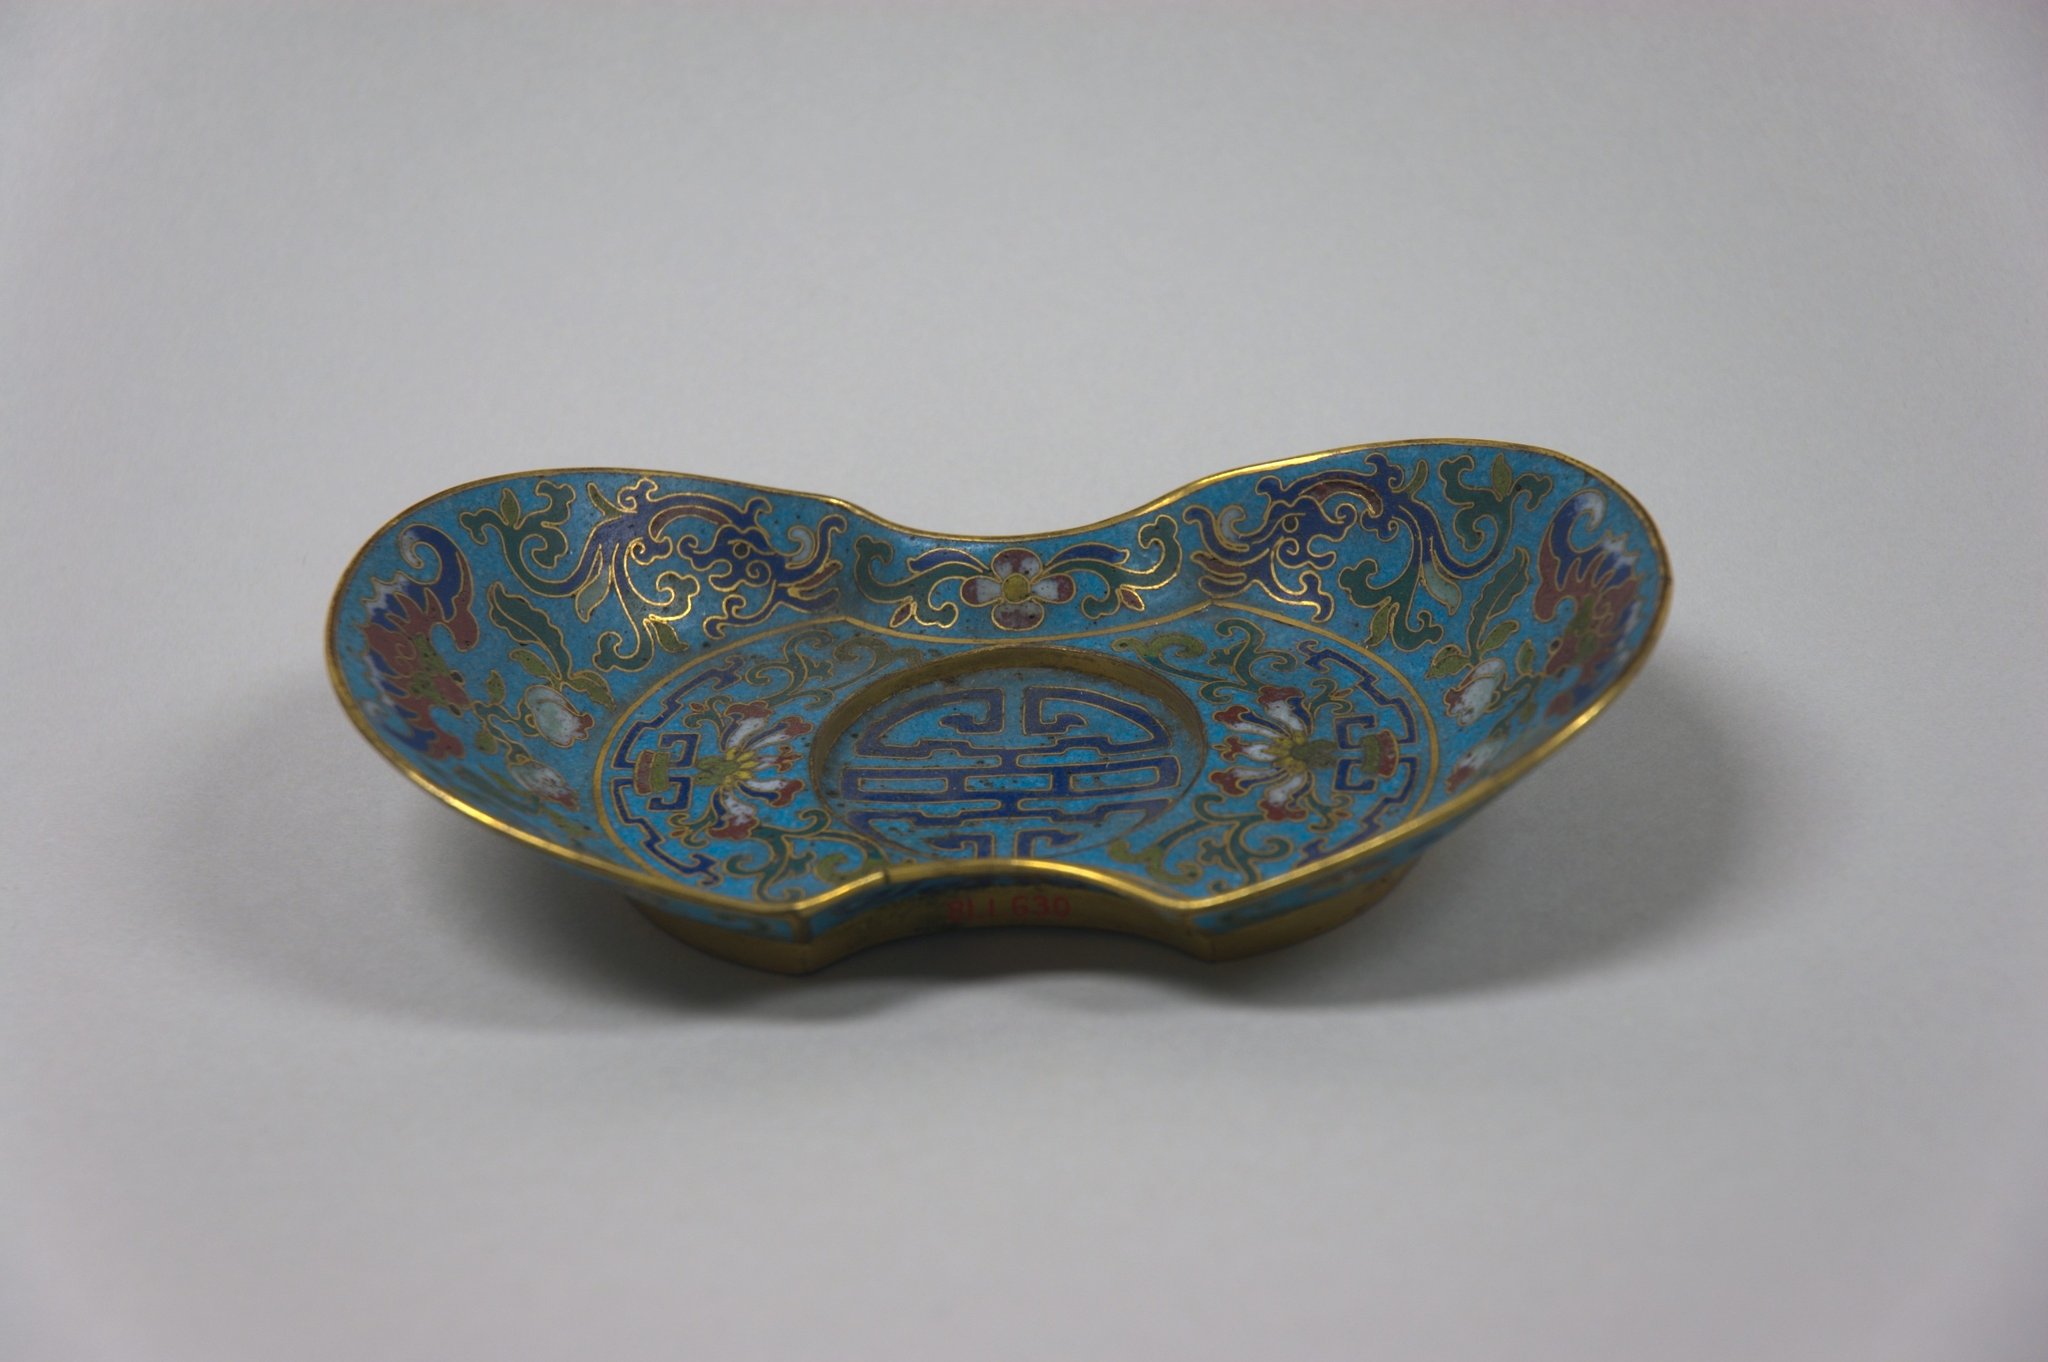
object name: tray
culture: chinese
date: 1701-1800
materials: enamel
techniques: enamel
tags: flowers